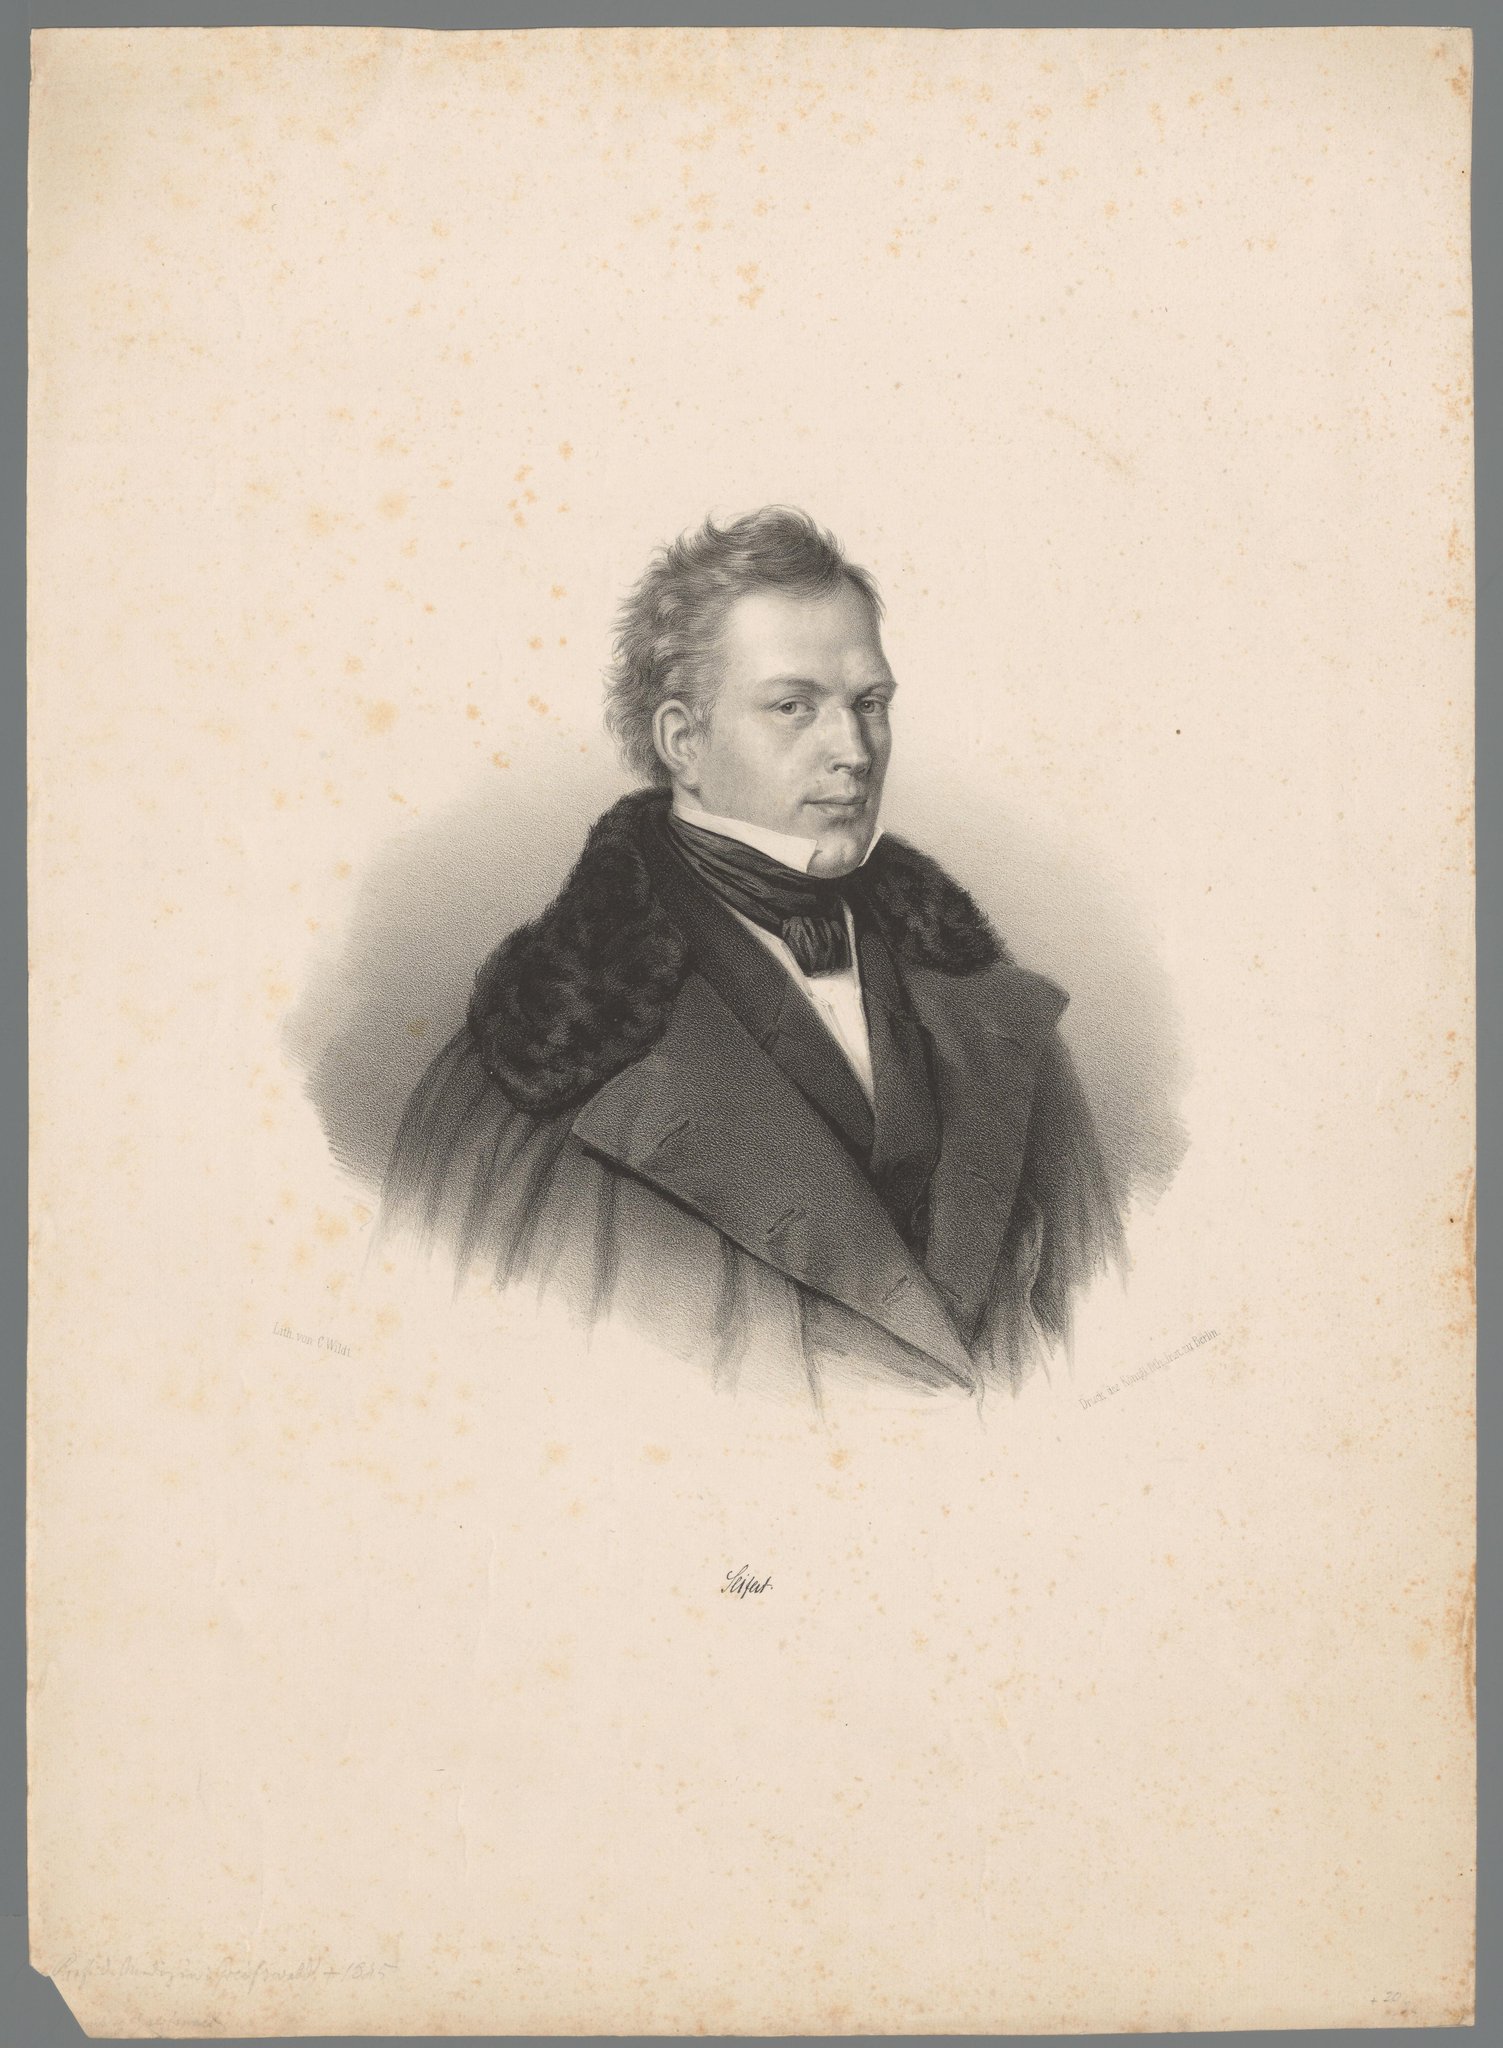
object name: print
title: Portret van Philipp Magnus Seifert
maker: carl wildt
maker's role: print maker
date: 1830-1860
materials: paper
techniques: lithograph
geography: berlin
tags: adult man, historical persons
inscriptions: collector's mark: Lugt 2228